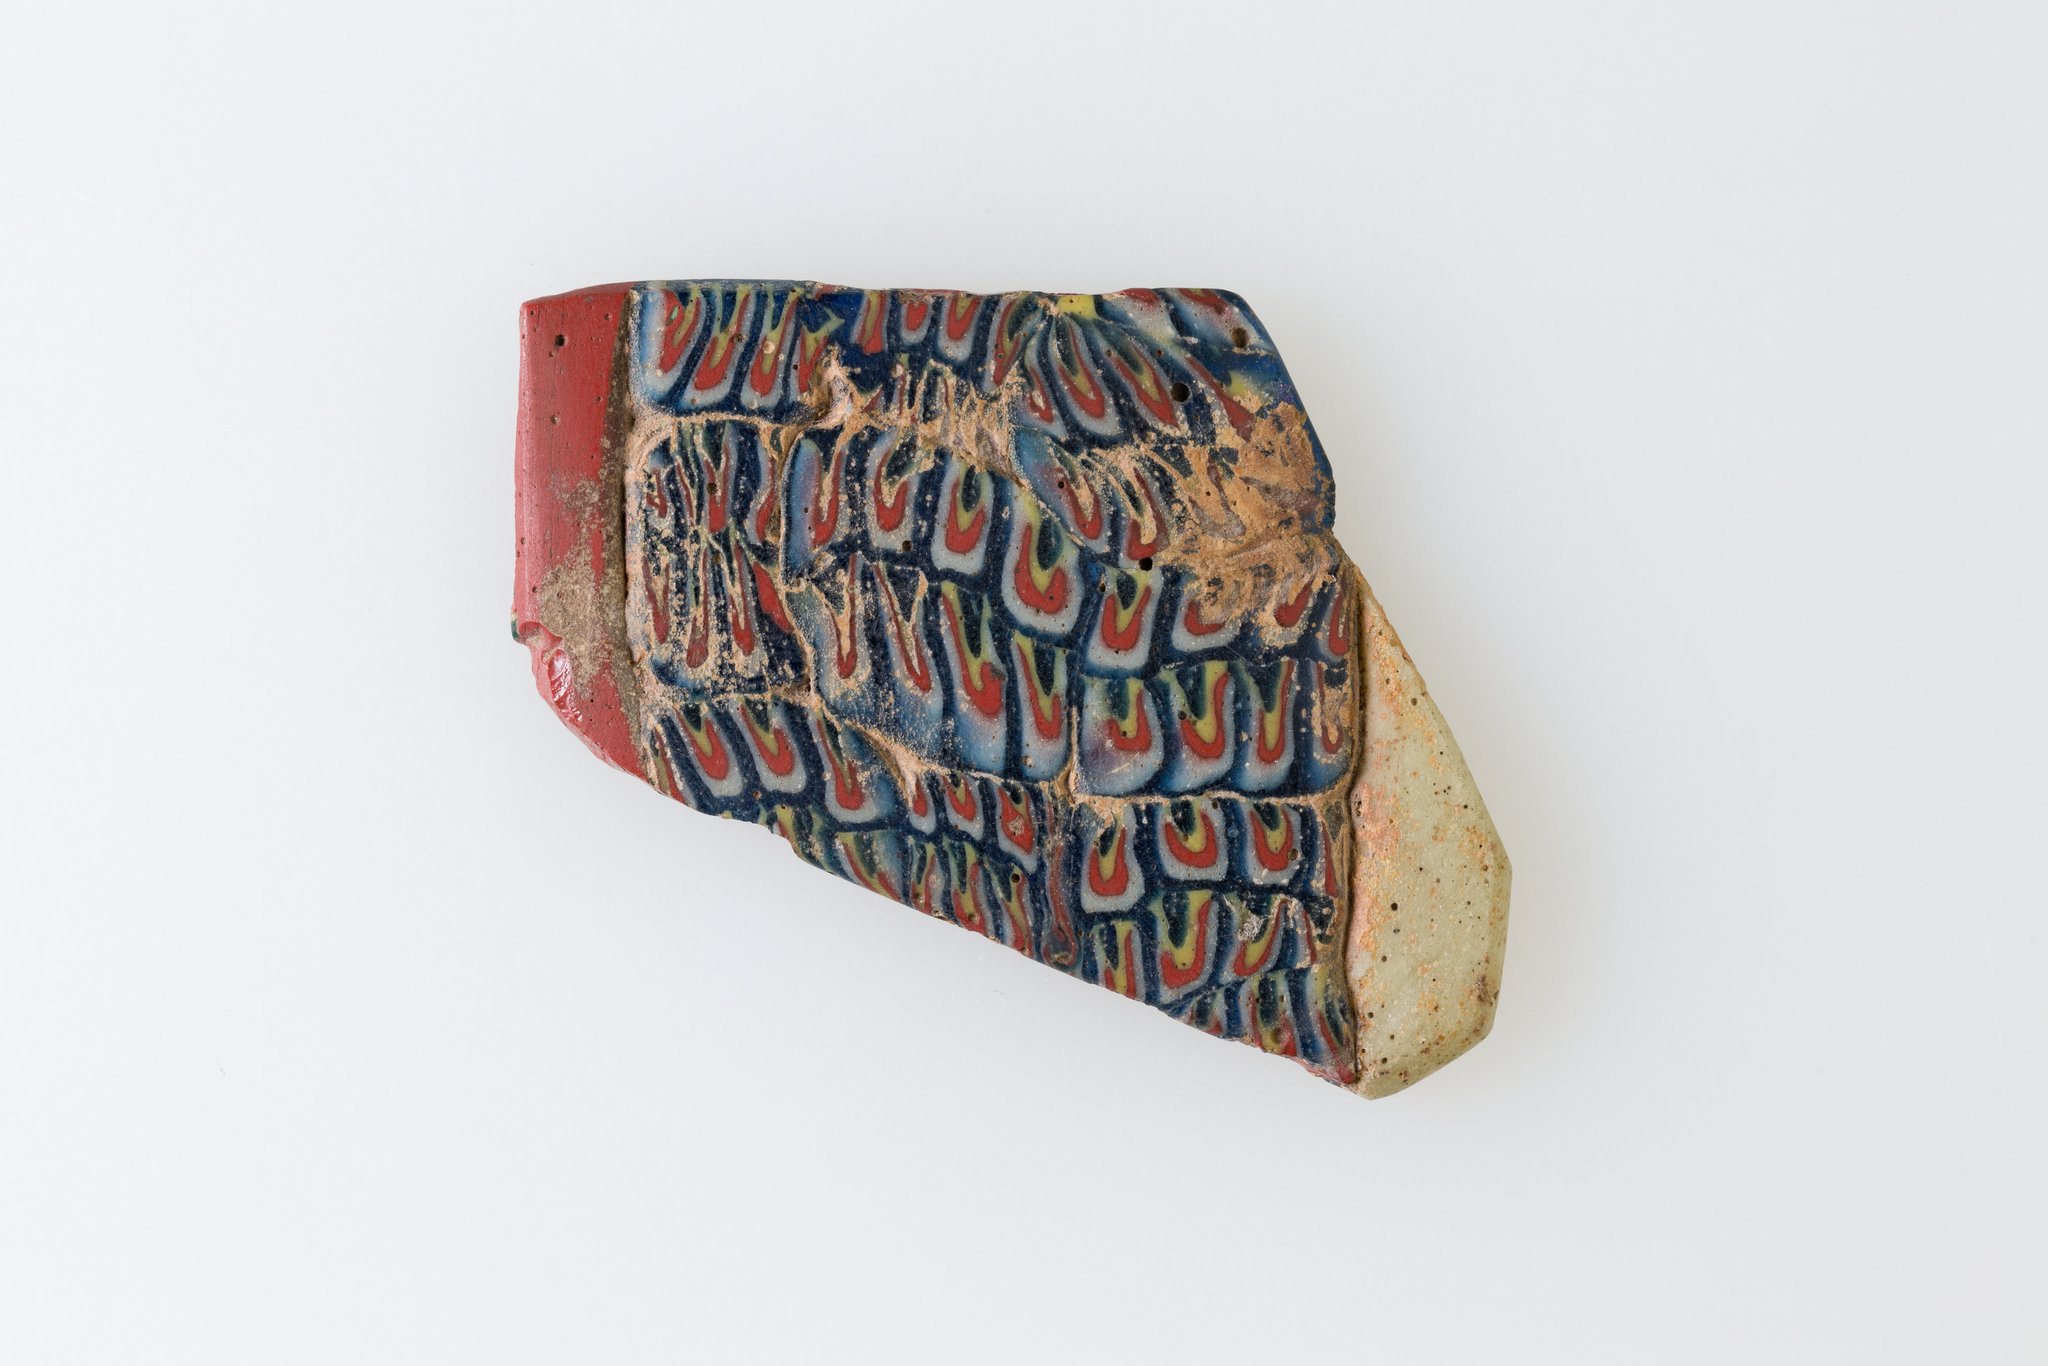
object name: inlay fragment, millefiori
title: Inlay fragment, feather(?) design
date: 1-300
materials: glass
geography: egypt